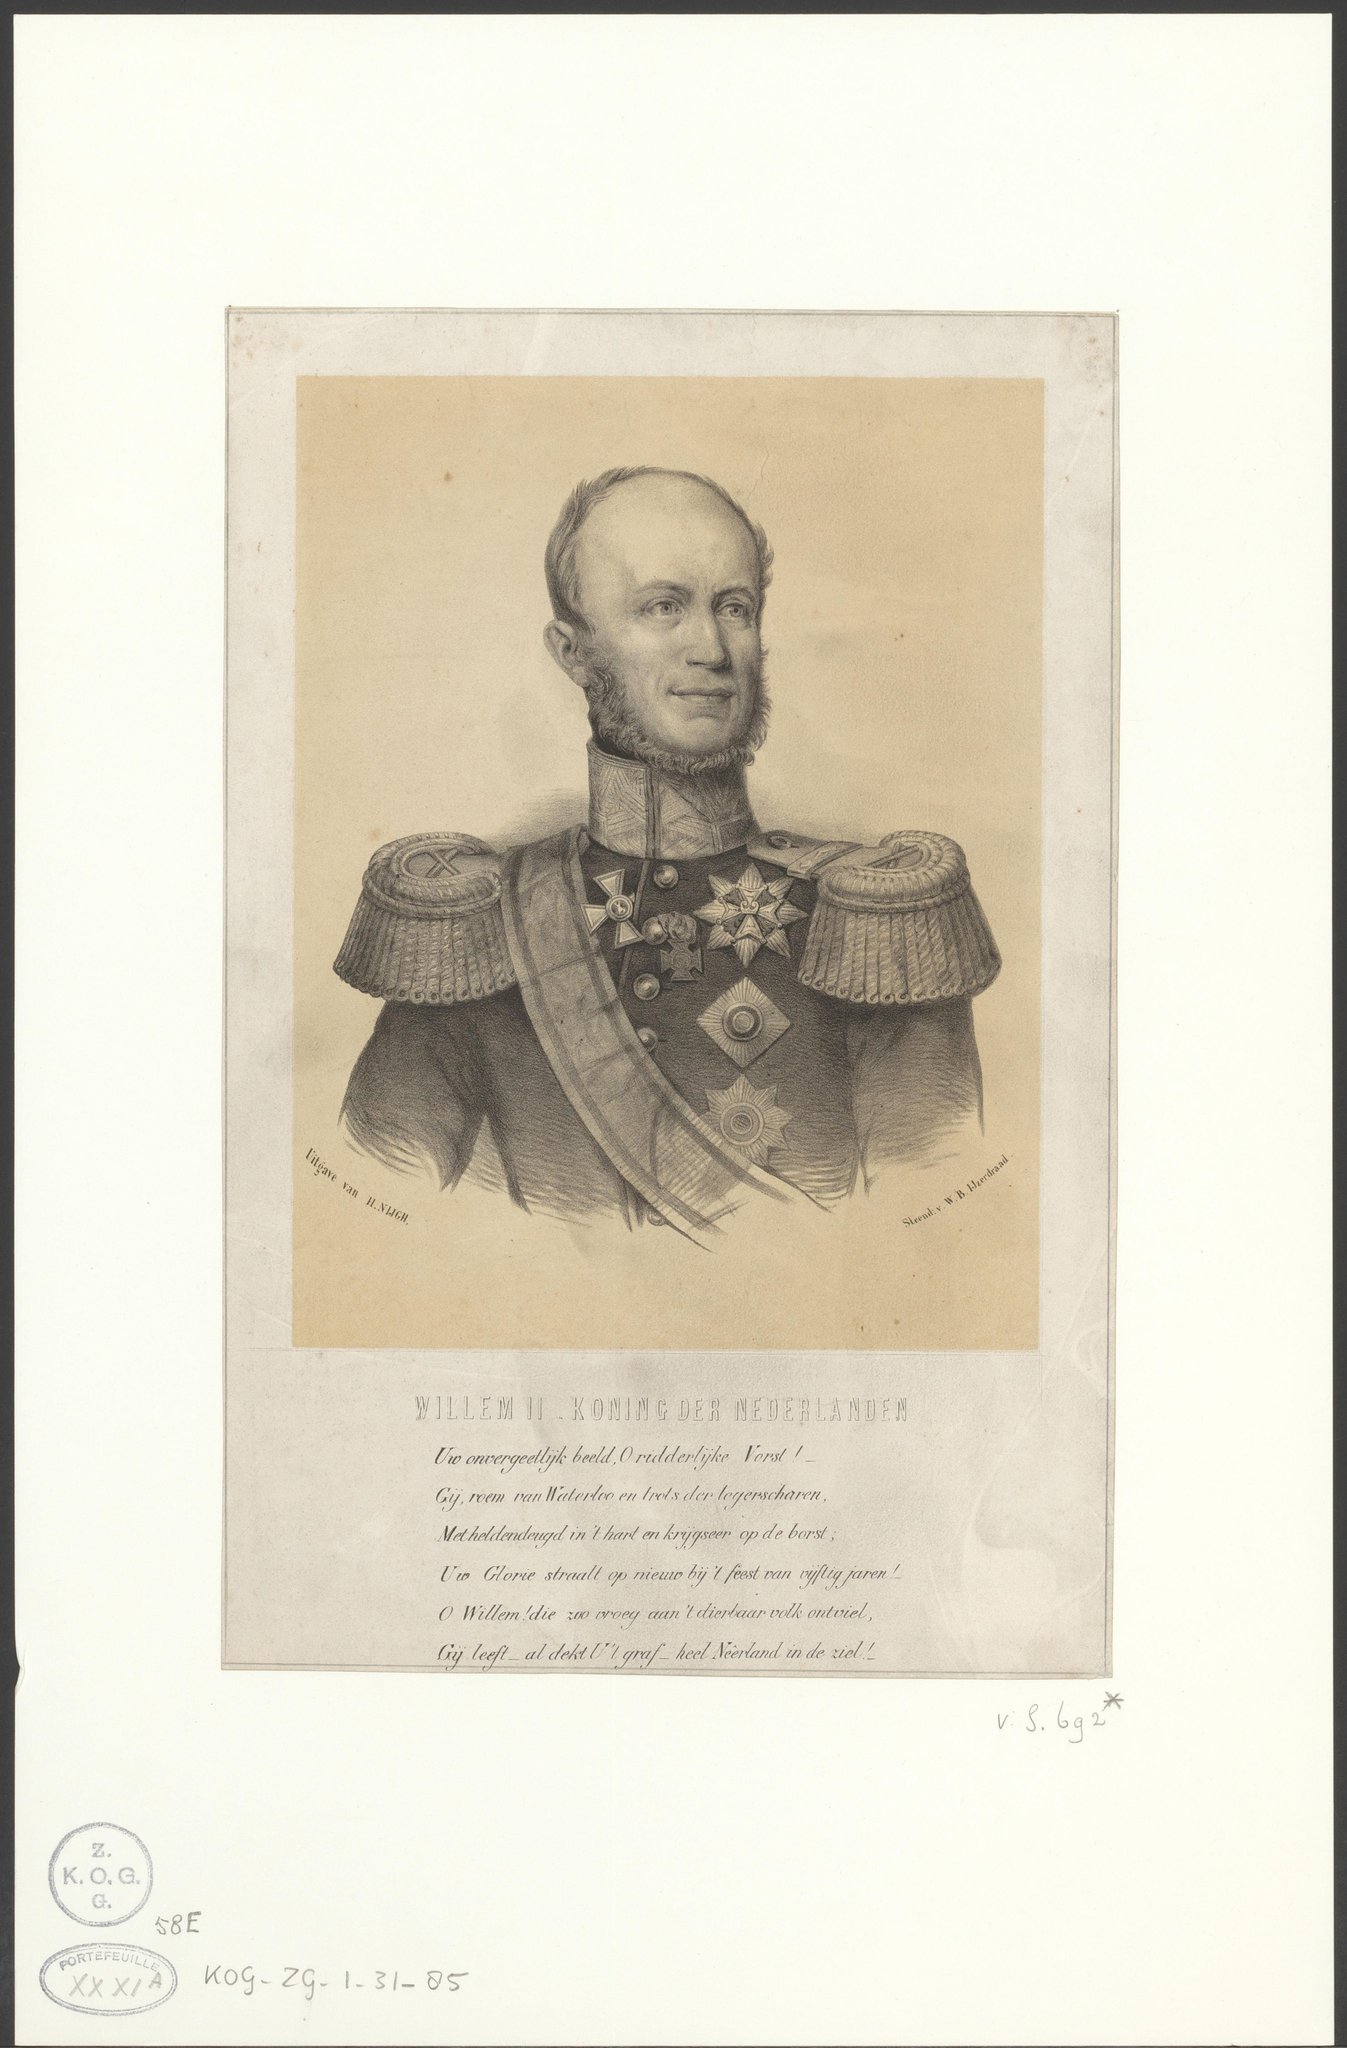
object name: print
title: Portret van Willem II, koning der Nederlanden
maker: willem bernardus ijzerdraat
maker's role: draughtsman, print maker, printer, publisher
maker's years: 1835-1907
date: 1850-1907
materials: paper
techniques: tone lithography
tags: the hague, william ii of the netherlands, historical persons, king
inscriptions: stamp, collector's mark: Lugt 1641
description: Onderaan een zesregelig vers. Onderwerpsrubrieken binnen de Atlas Zeden en Gewoonten: Portretten, Portretten van Vorsten uit het huis van Oranje, Regeerende Vorsten, Koningen uit het huis van Oranje.